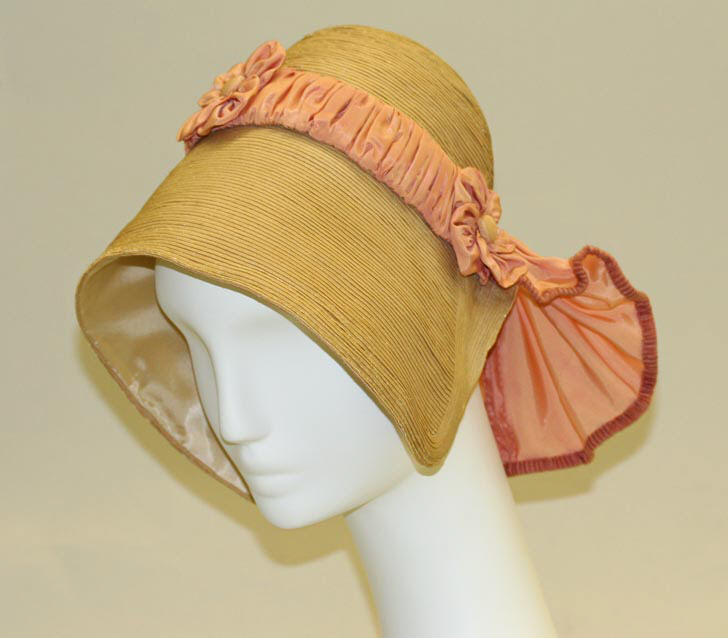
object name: bonnet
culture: american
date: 1830-1839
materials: fiber